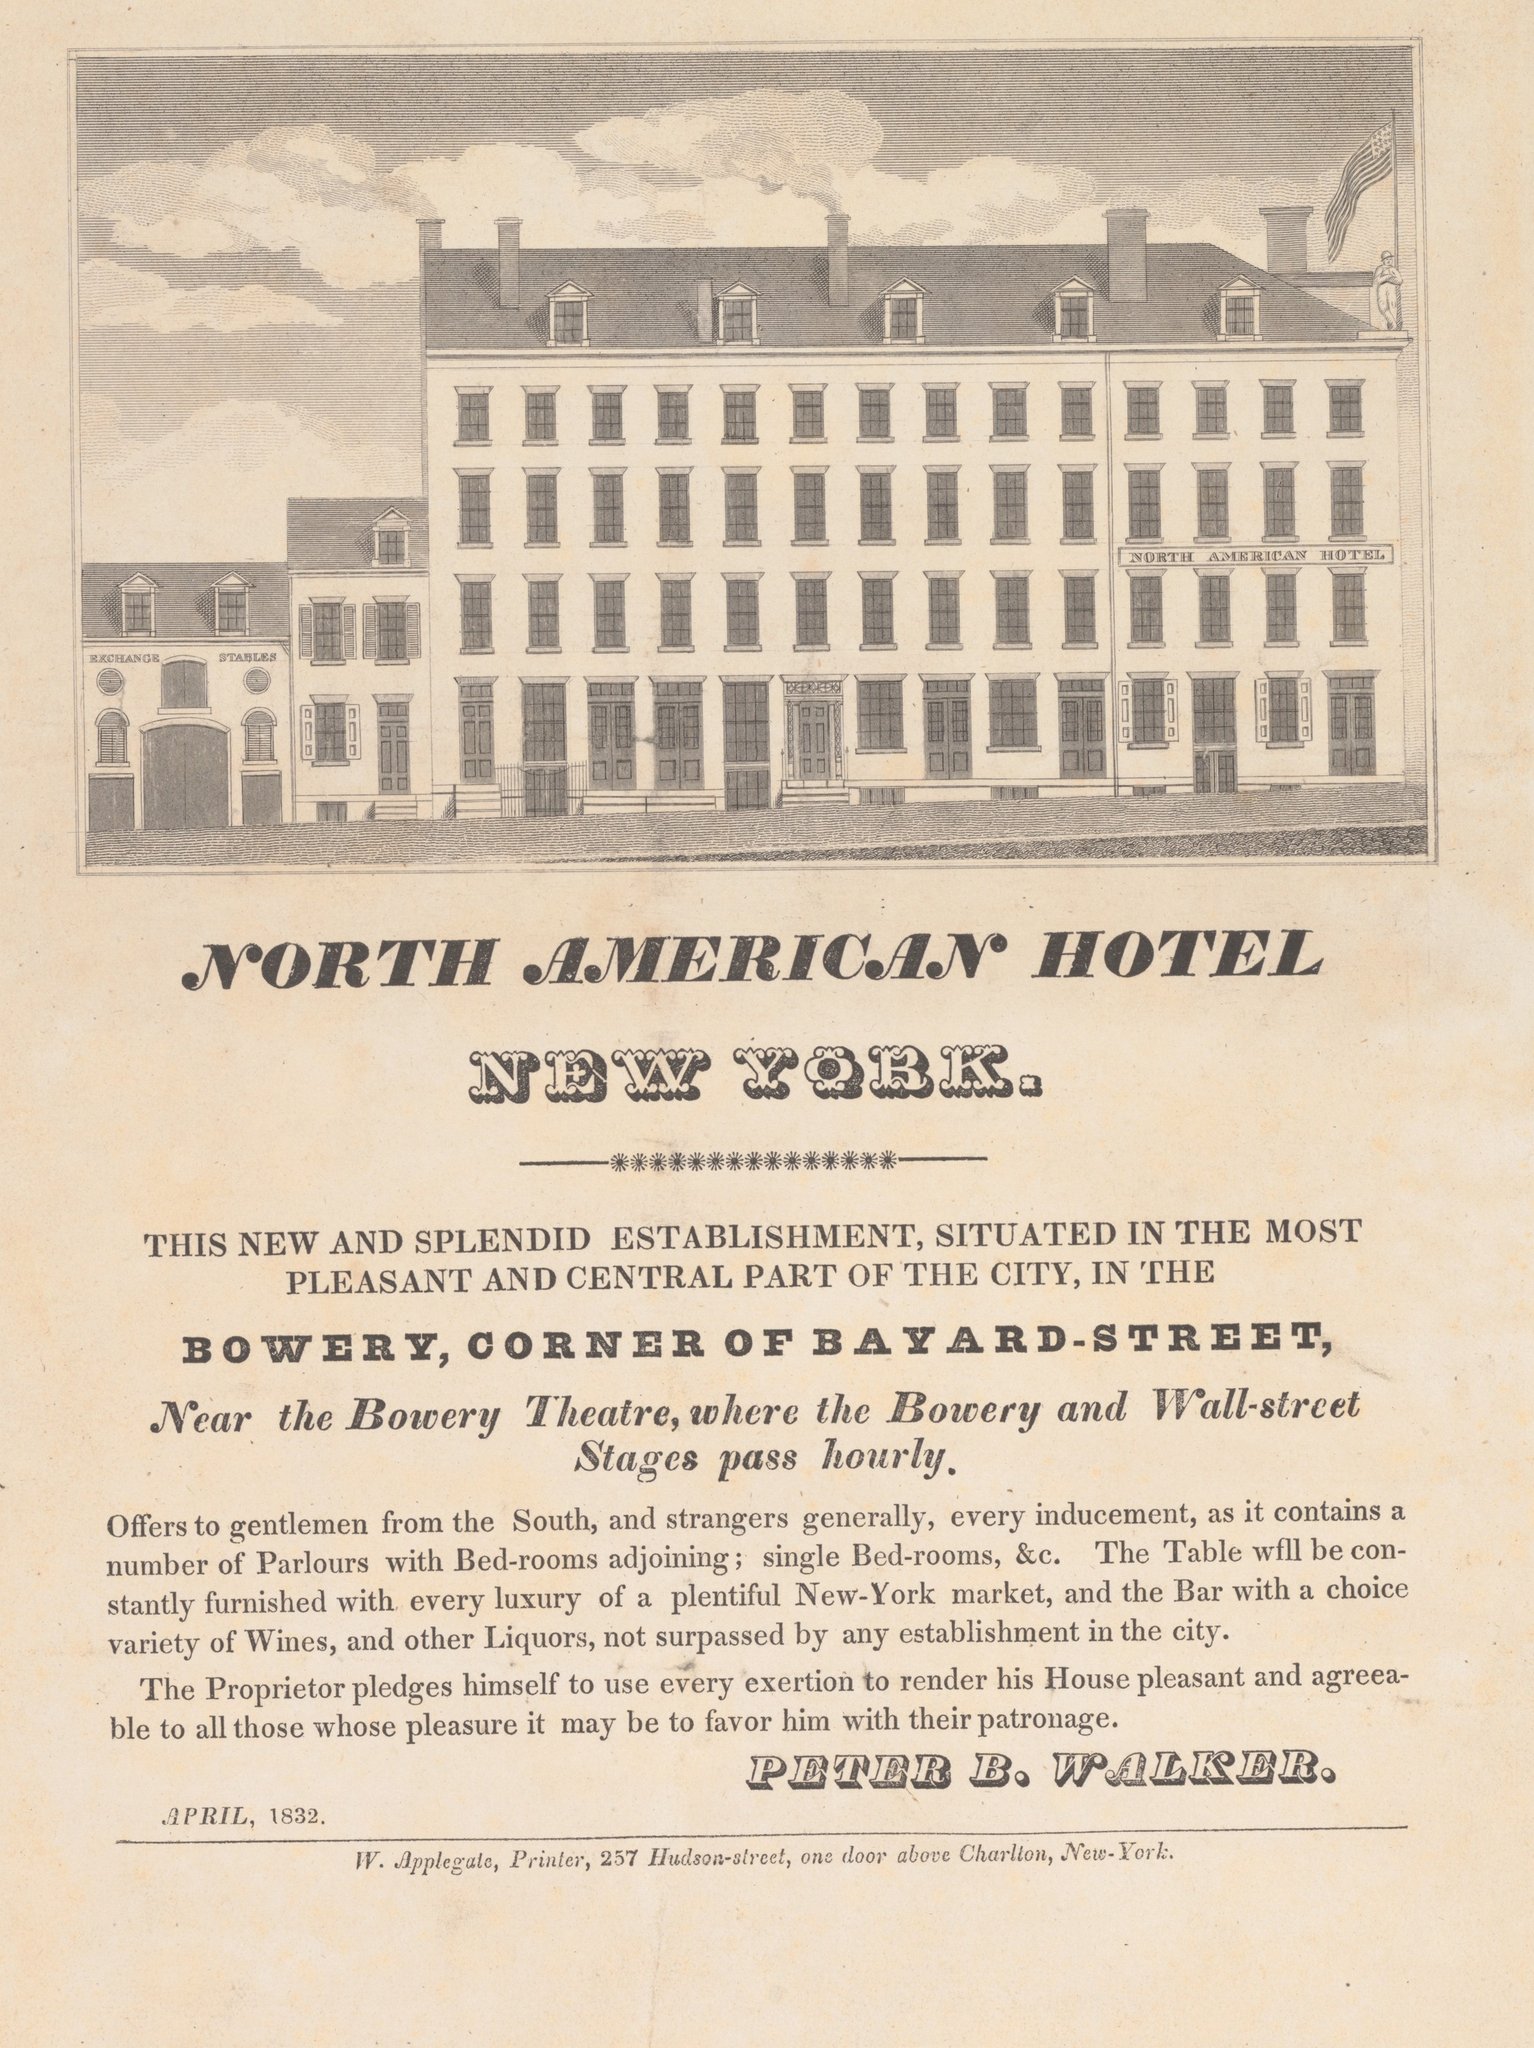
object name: print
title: North American Hotel, New York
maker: peter b. walker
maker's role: author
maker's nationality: american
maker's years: 1800-1900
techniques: engraving, etching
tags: hotels